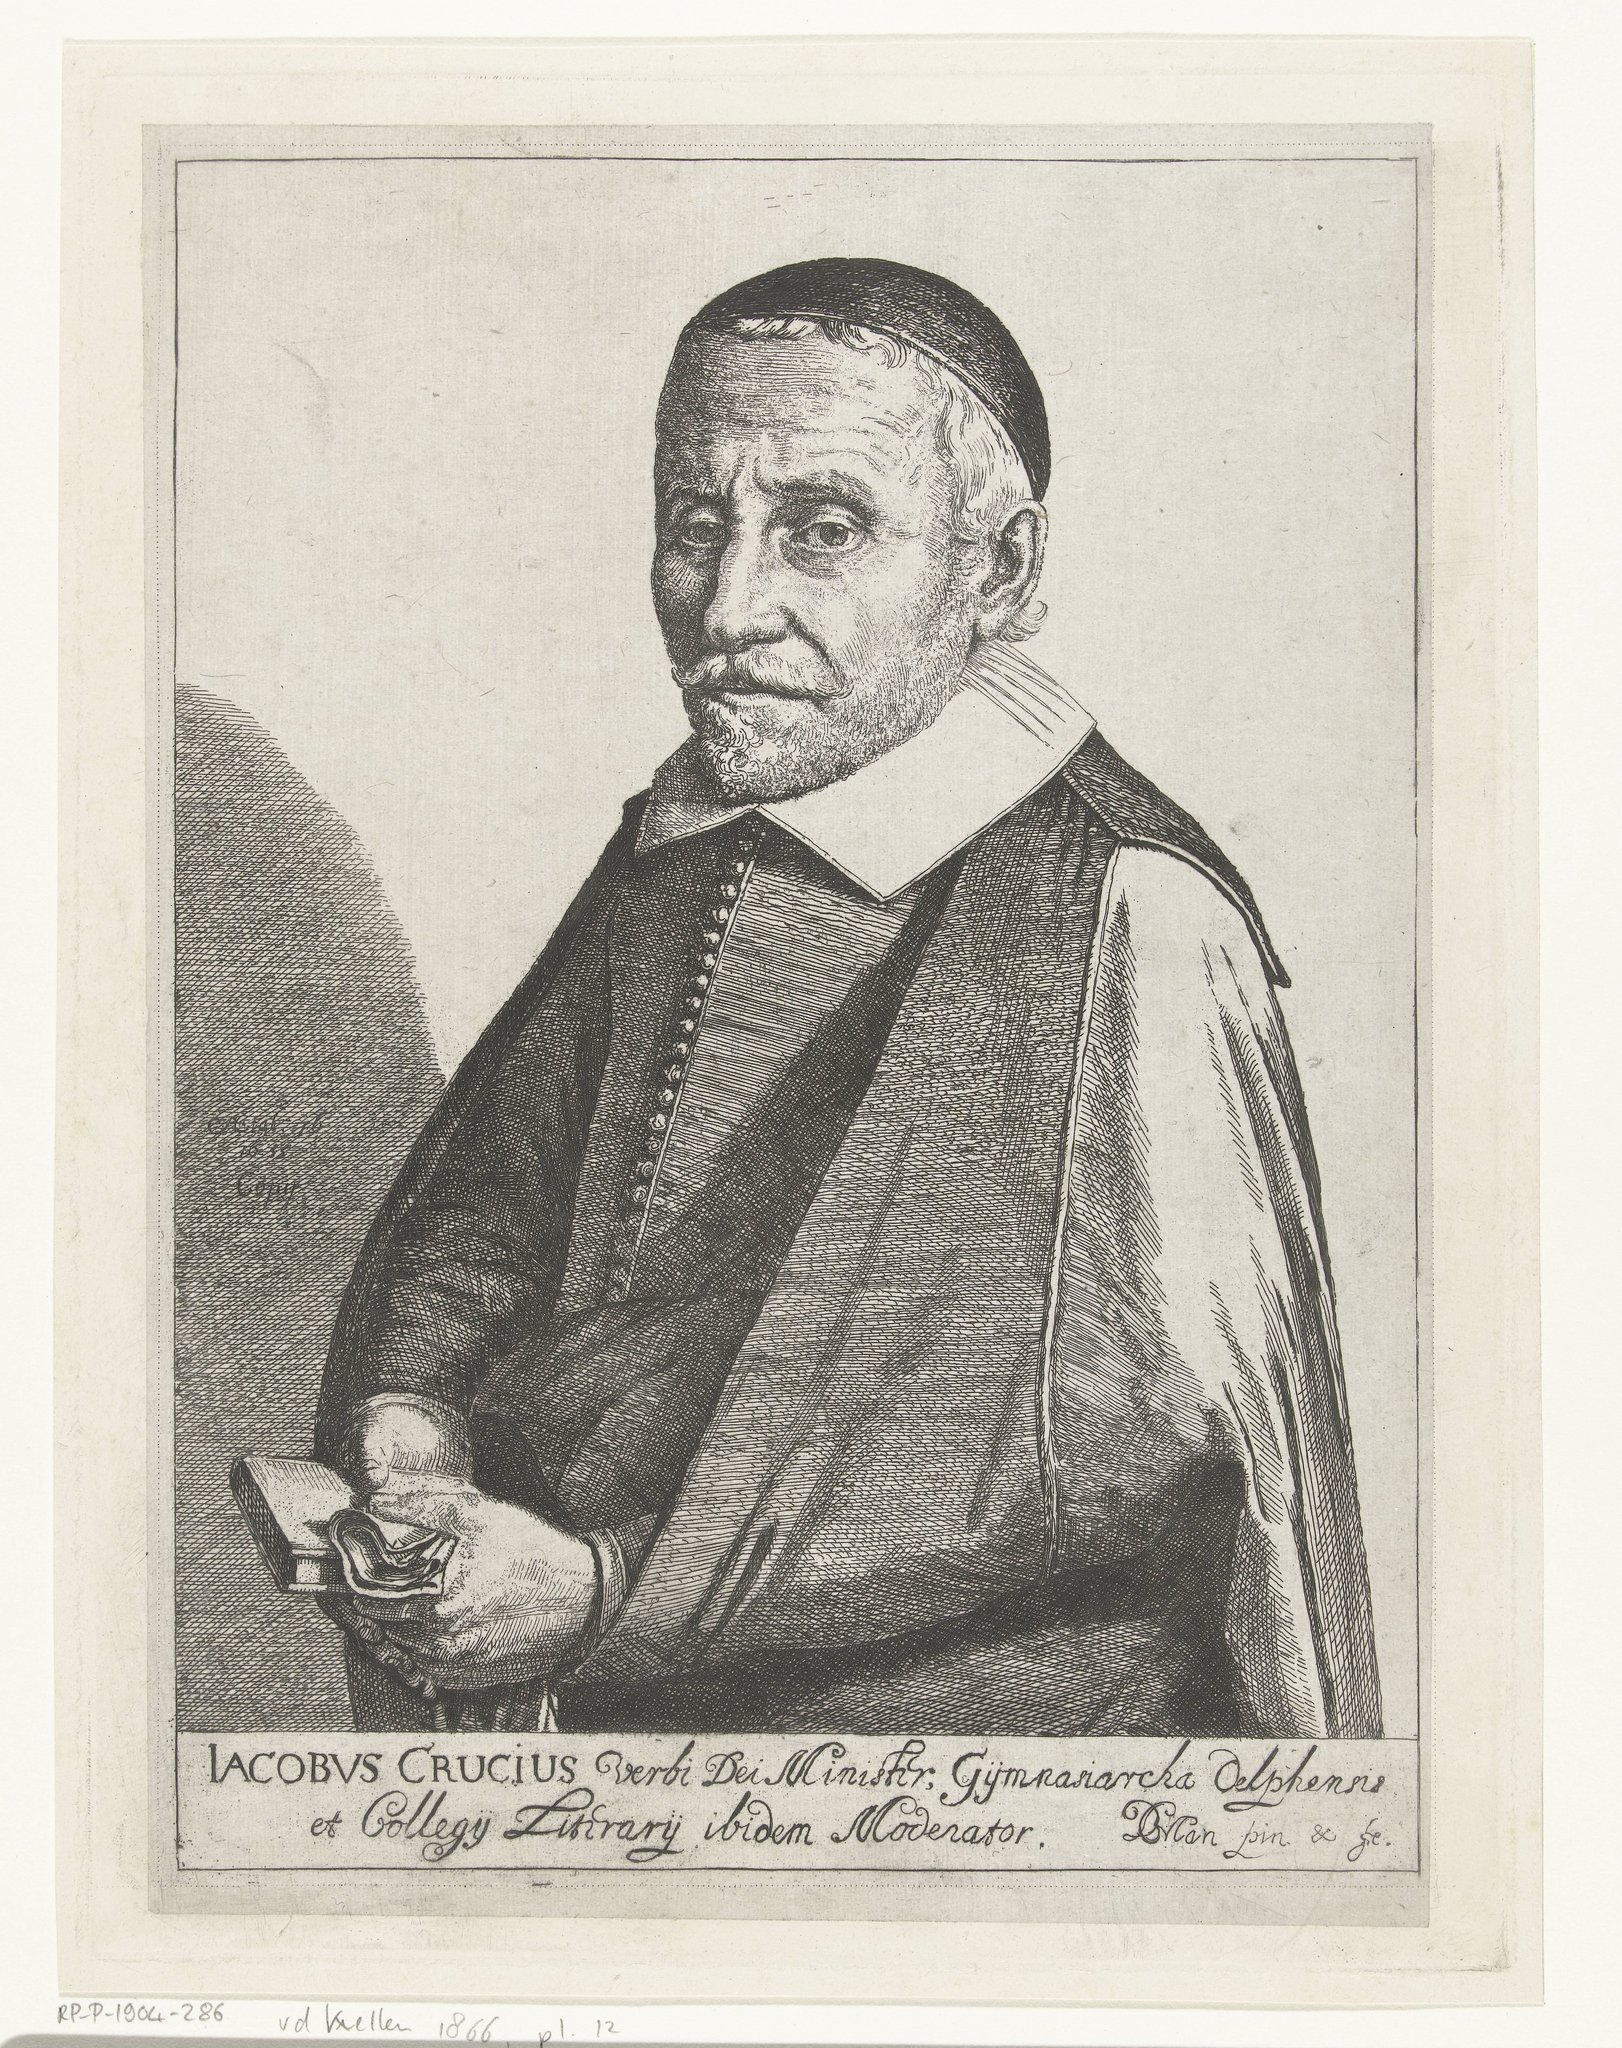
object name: print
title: Portret van Jacobus Crucius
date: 1866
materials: paper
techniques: etching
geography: amsterdam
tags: jacobus crucius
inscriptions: collector's mark: Lugt 2228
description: Illustratie voor J.P. van der Kellen, Le peintre graveur hollandais et flamand, Utrecht: 1866.